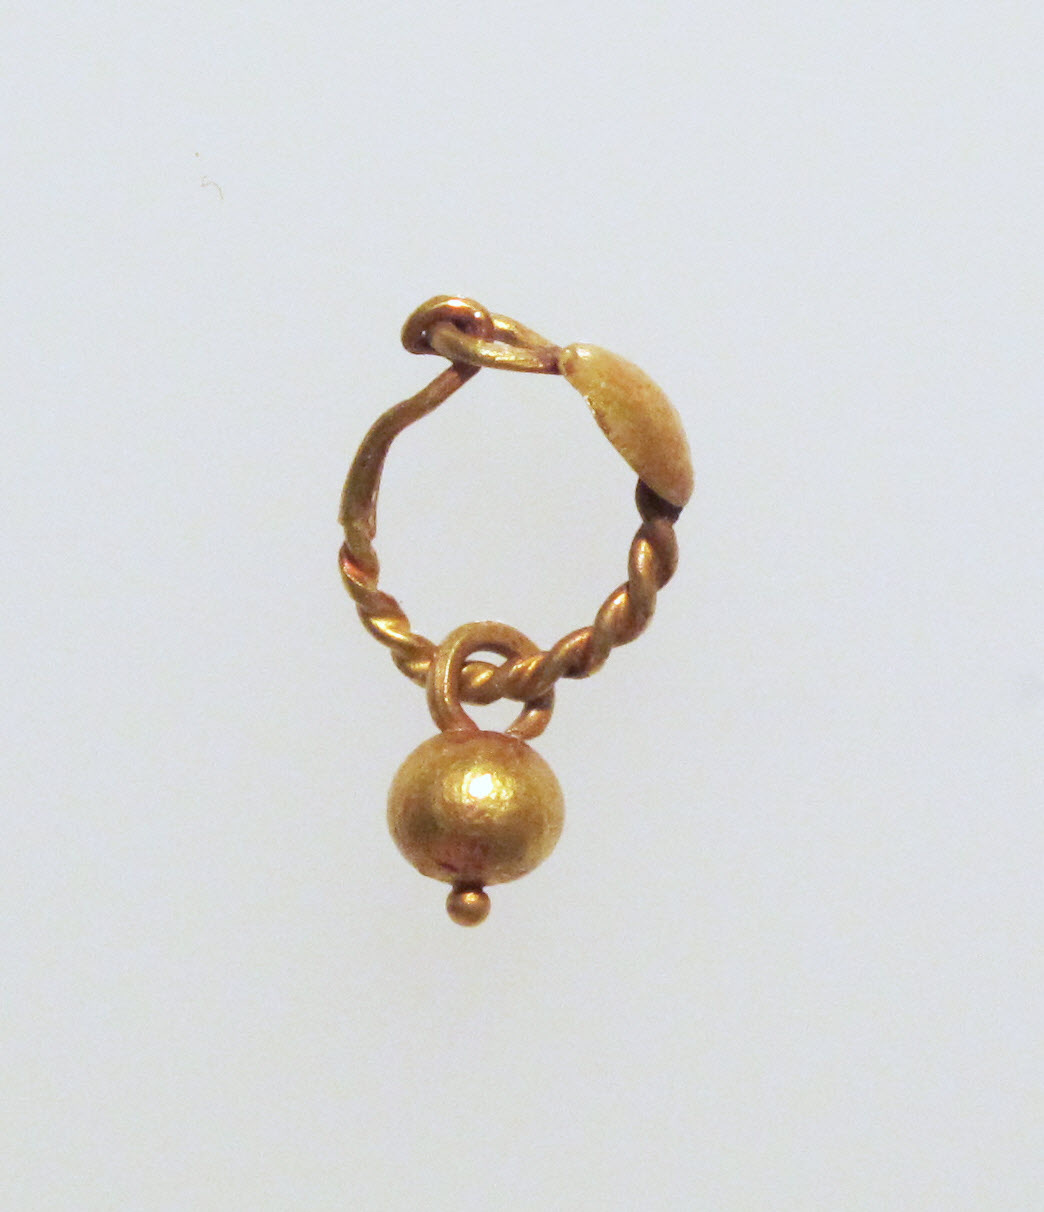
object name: earring with ball pendant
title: Gold earring with disc and pendant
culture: roman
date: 101-200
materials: gold